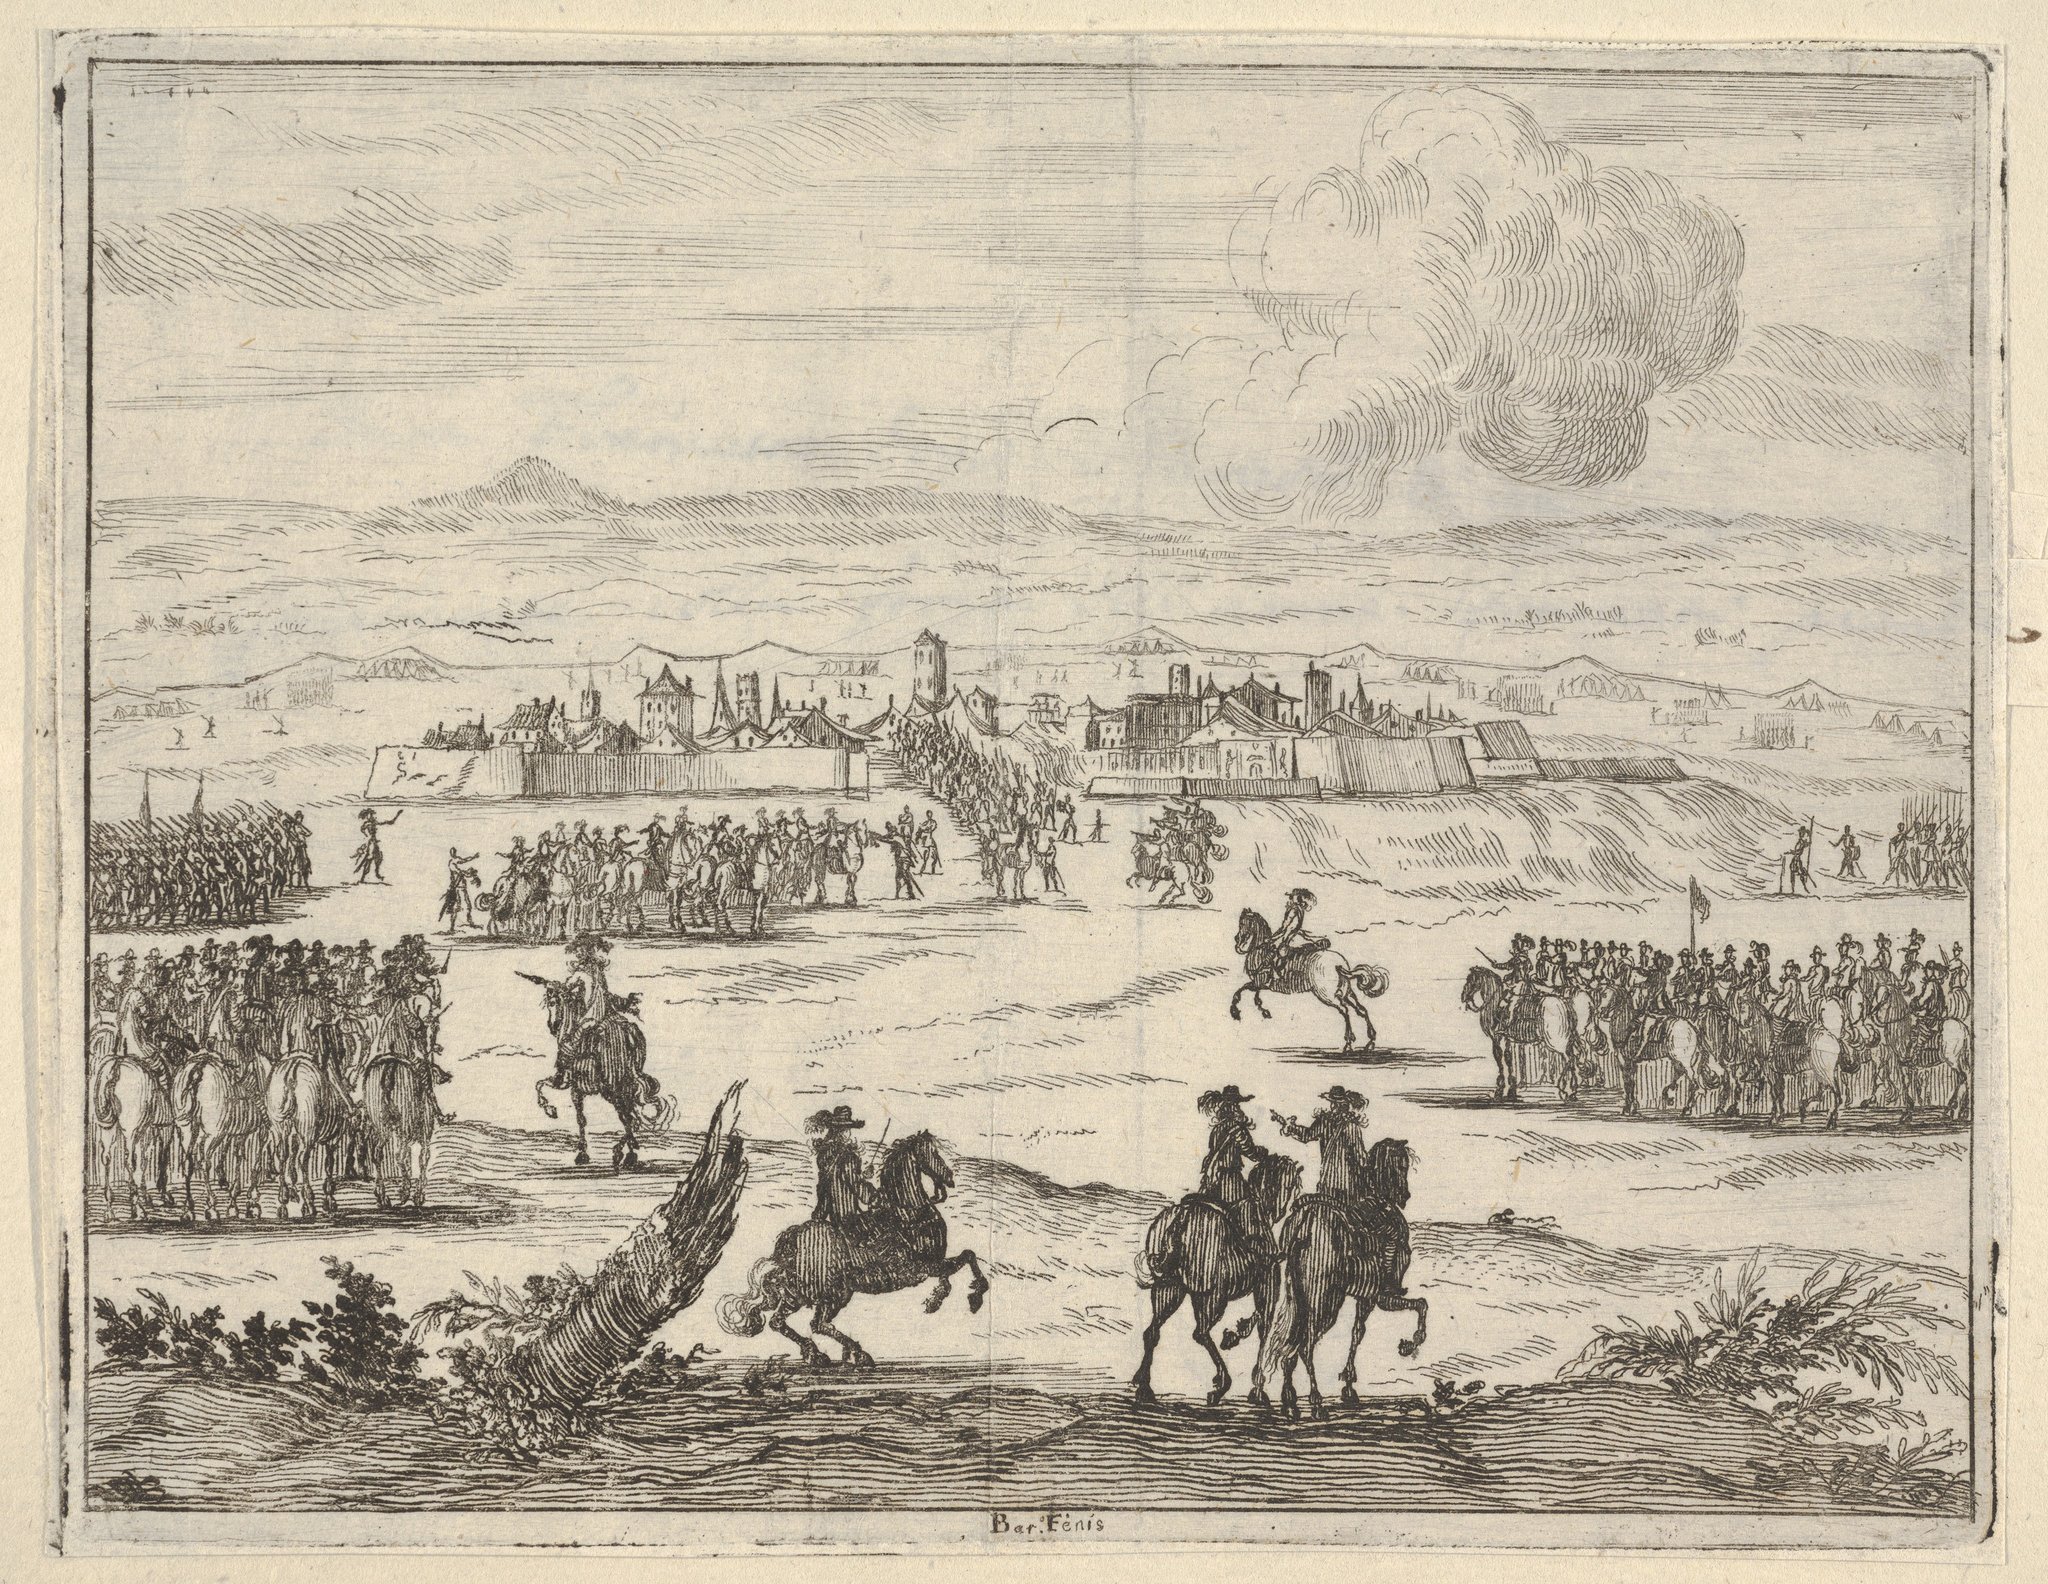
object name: print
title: After a Long Seige, Francesco I d'Este, with the Aid of the French Army, Takes Valencia, from "L'Idea di un Principe ed Eroe Cristiano in Francesco I d'Este, di Modena e Reggio Duca VIII [...]"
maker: bartolomeo fenice (fénis)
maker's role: artist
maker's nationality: italian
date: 1659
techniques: etching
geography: italy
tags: cities,army,horses